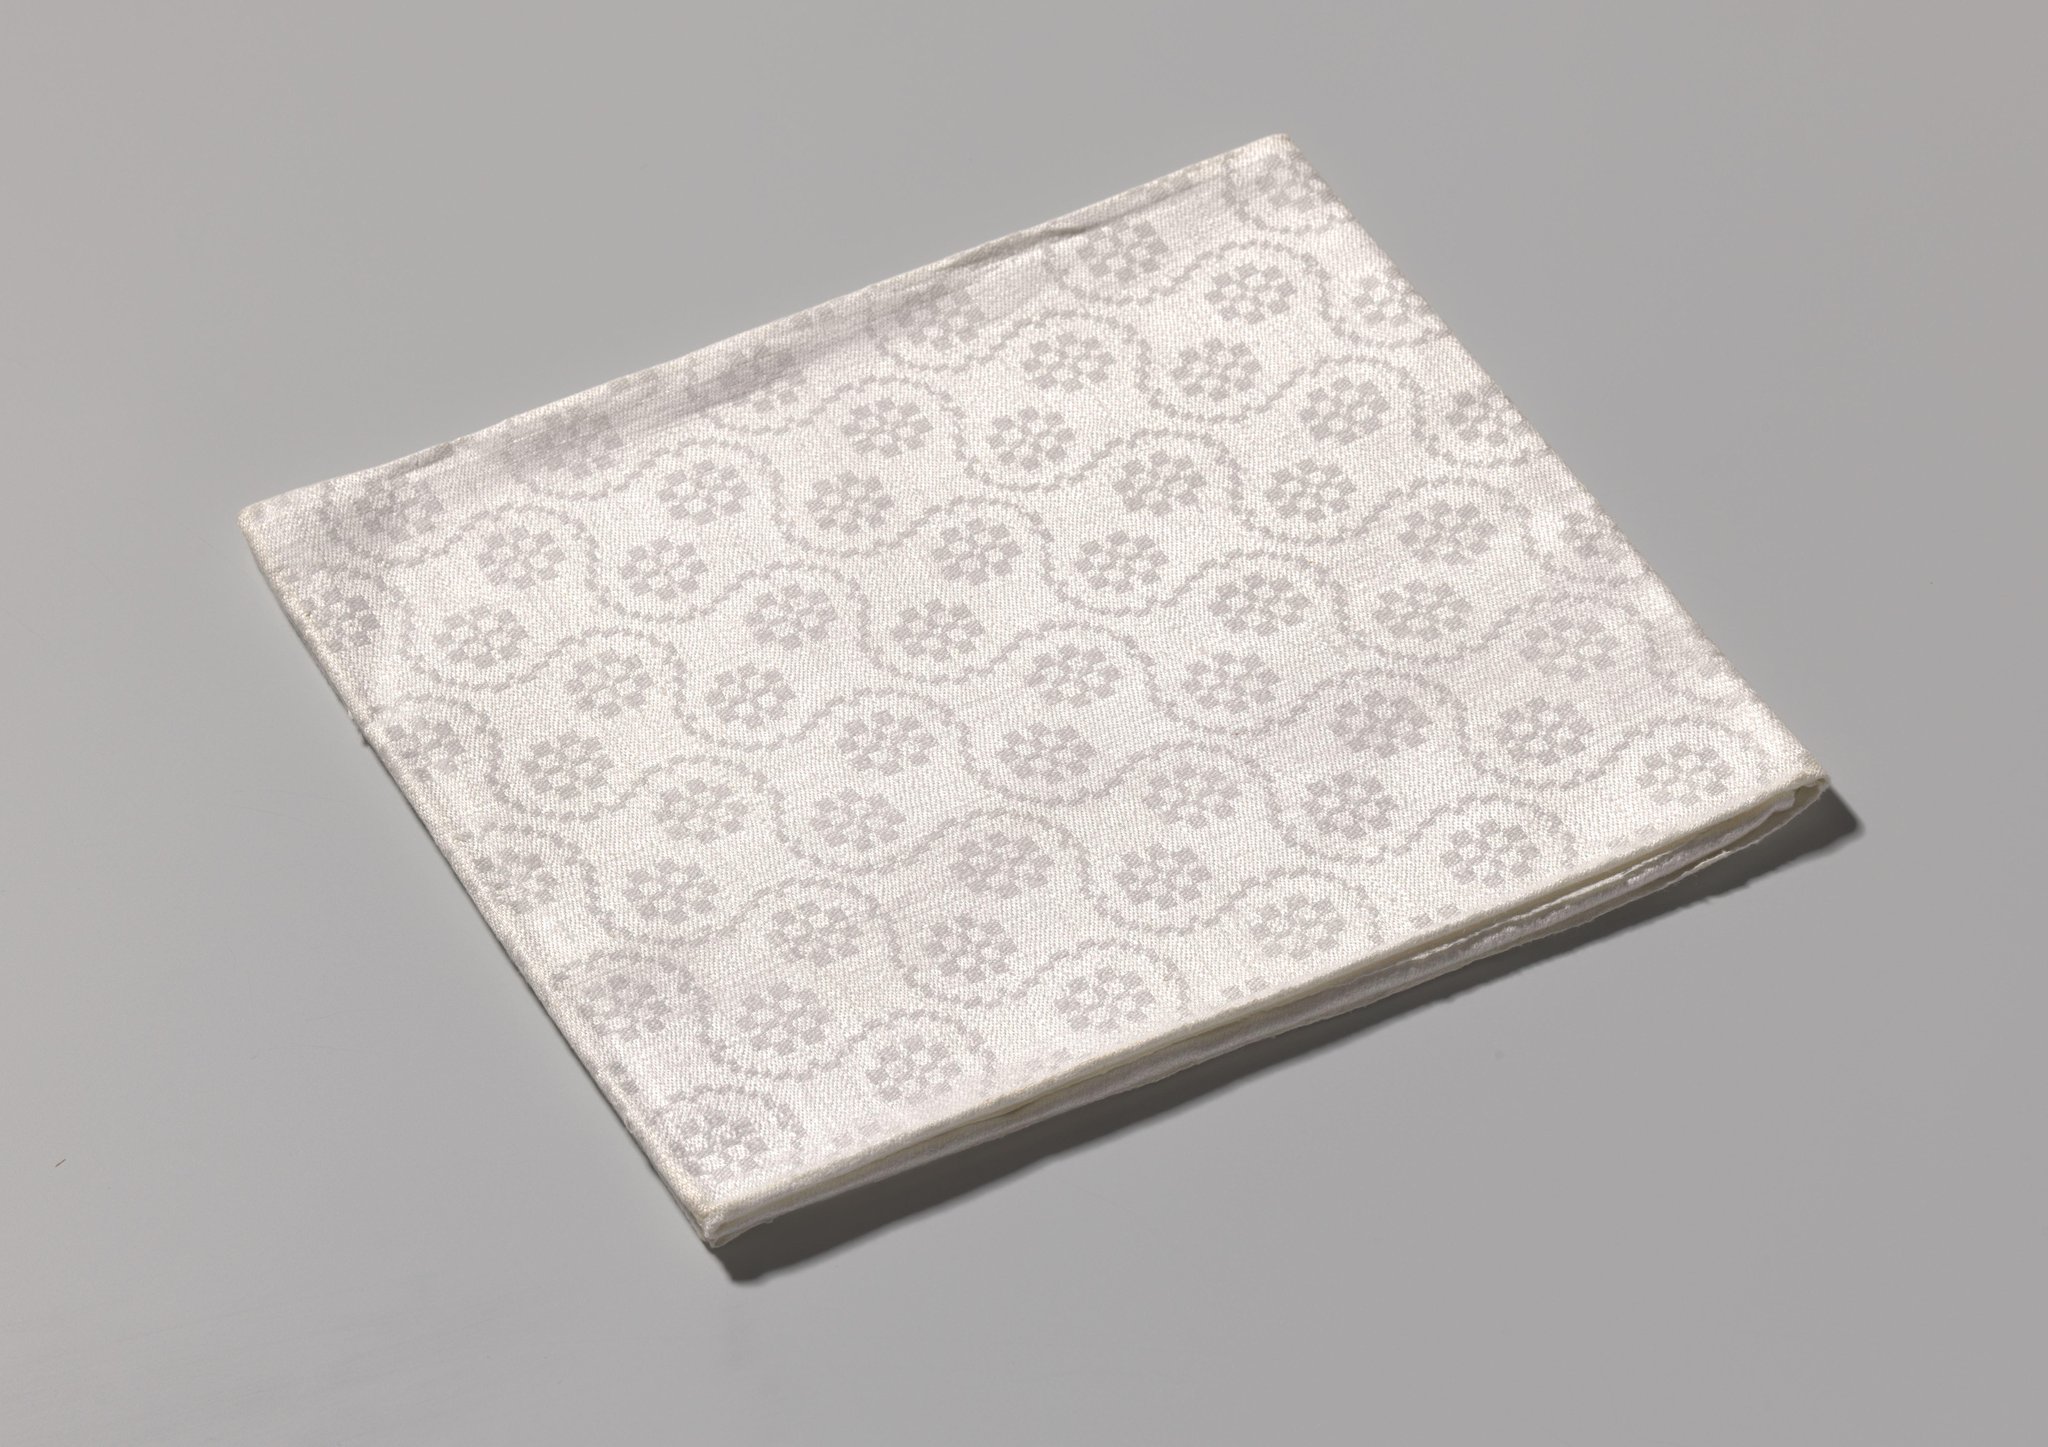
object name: napkin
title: Servet van linnen met pellenpatroon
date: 1800-1870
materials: linen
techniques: peeled fabric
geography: northern netherlands